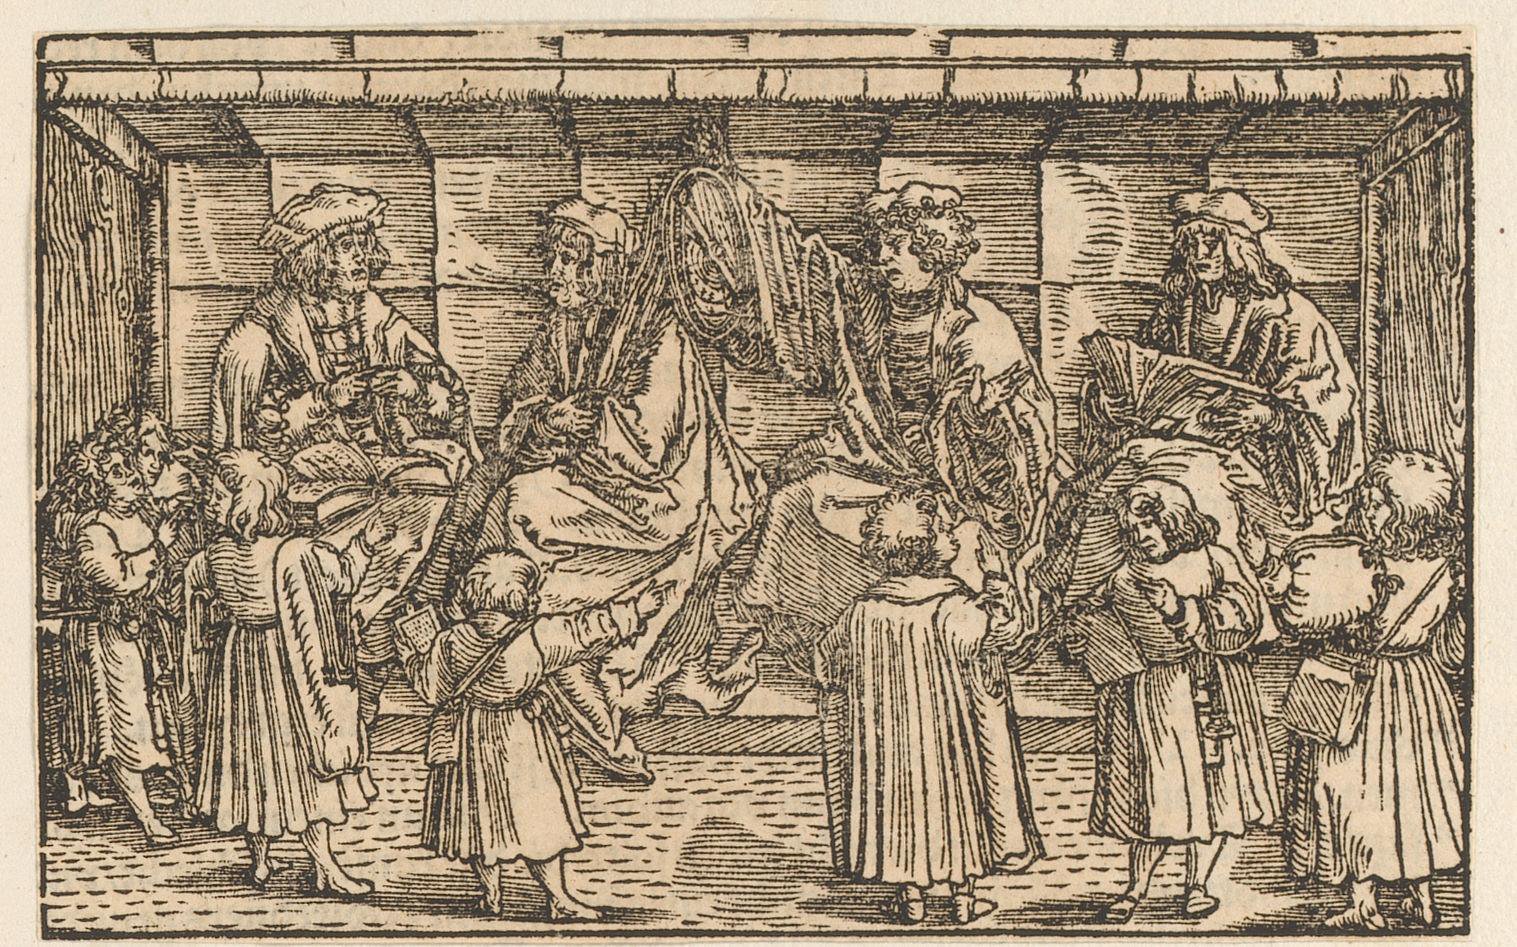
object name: album leaf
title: Vier leraren op een bank met kinderen daarvoor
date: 1514-1532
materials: paper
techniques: letterpress printing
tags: teacher and pupil, book, clock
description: Deze prent is gebruikt in: Petrarca, Francesco. Von der Artzney bayder Glück, des guten und widerwertigen: unnd weß sich ain yeder inn Gelück und Unglück halten sol (...). Augsburg: Heinrich Steiner, 1532. Deze uitgave is ook bekend onder de titel 'Trostspiegel in Glück und Unglück'. Deze prent is ook gebruikt in: Cicero, Marcus Tulius. Officia M.T.C. Ein Buch so Marcus Tullius Cicero der Römer zu seynem (...). [Vertaald uit het Latijn door] Johann von Schwarzenberg. Augsburg: Heinrich Steiner, 1531.